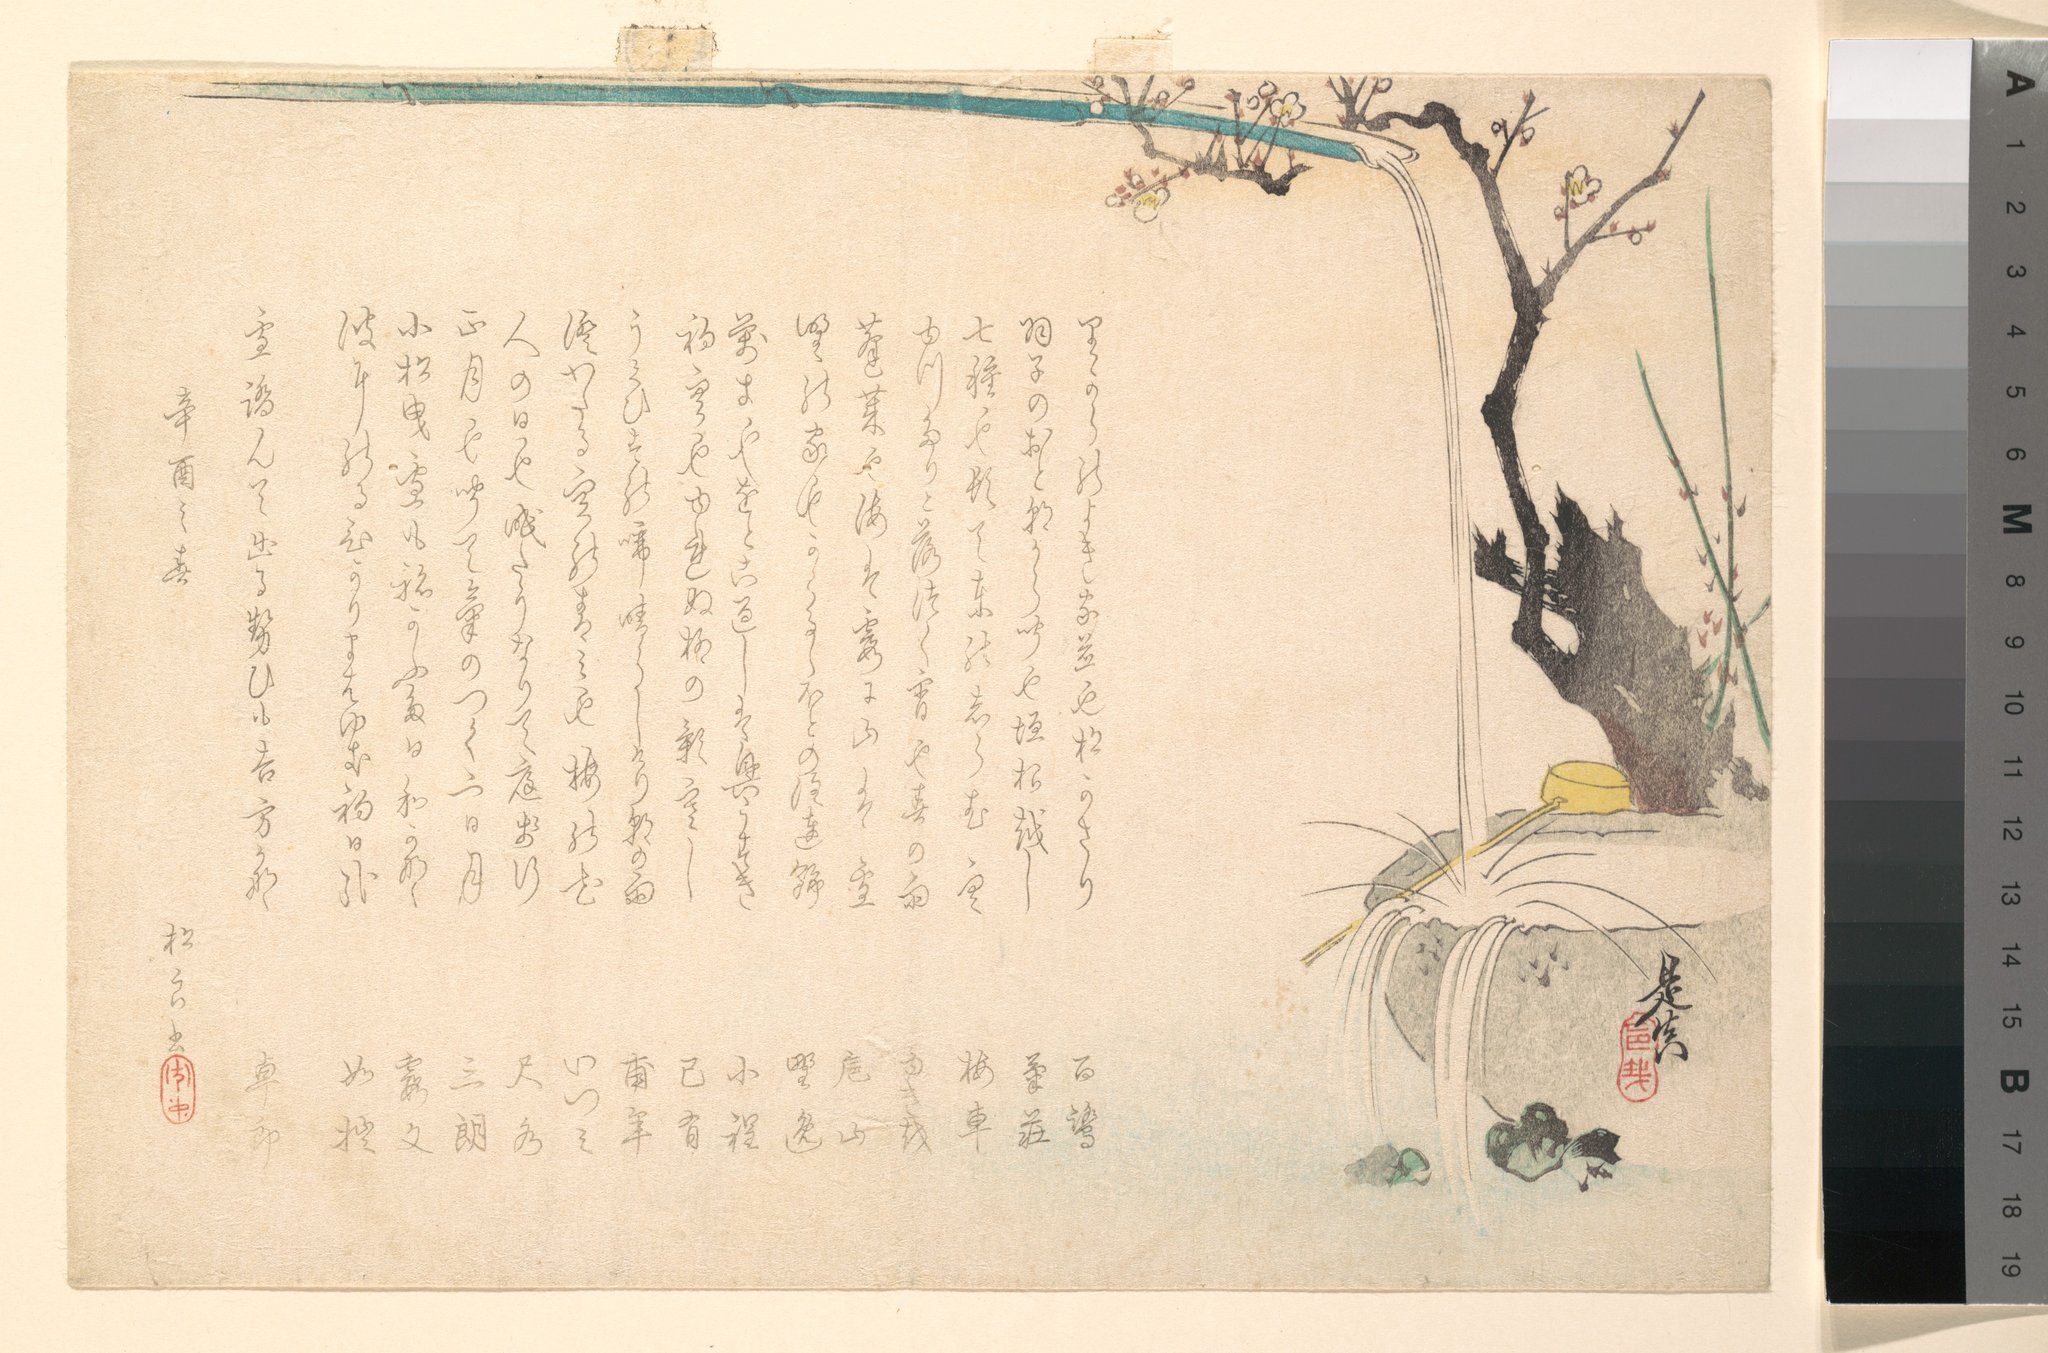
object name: print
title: Surimono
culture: japanese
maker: shibata zeshin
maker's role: artist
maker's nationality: japanese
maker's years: 1807-1891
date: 1860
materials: ink, paper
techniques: woodblock print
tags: flowers,trees